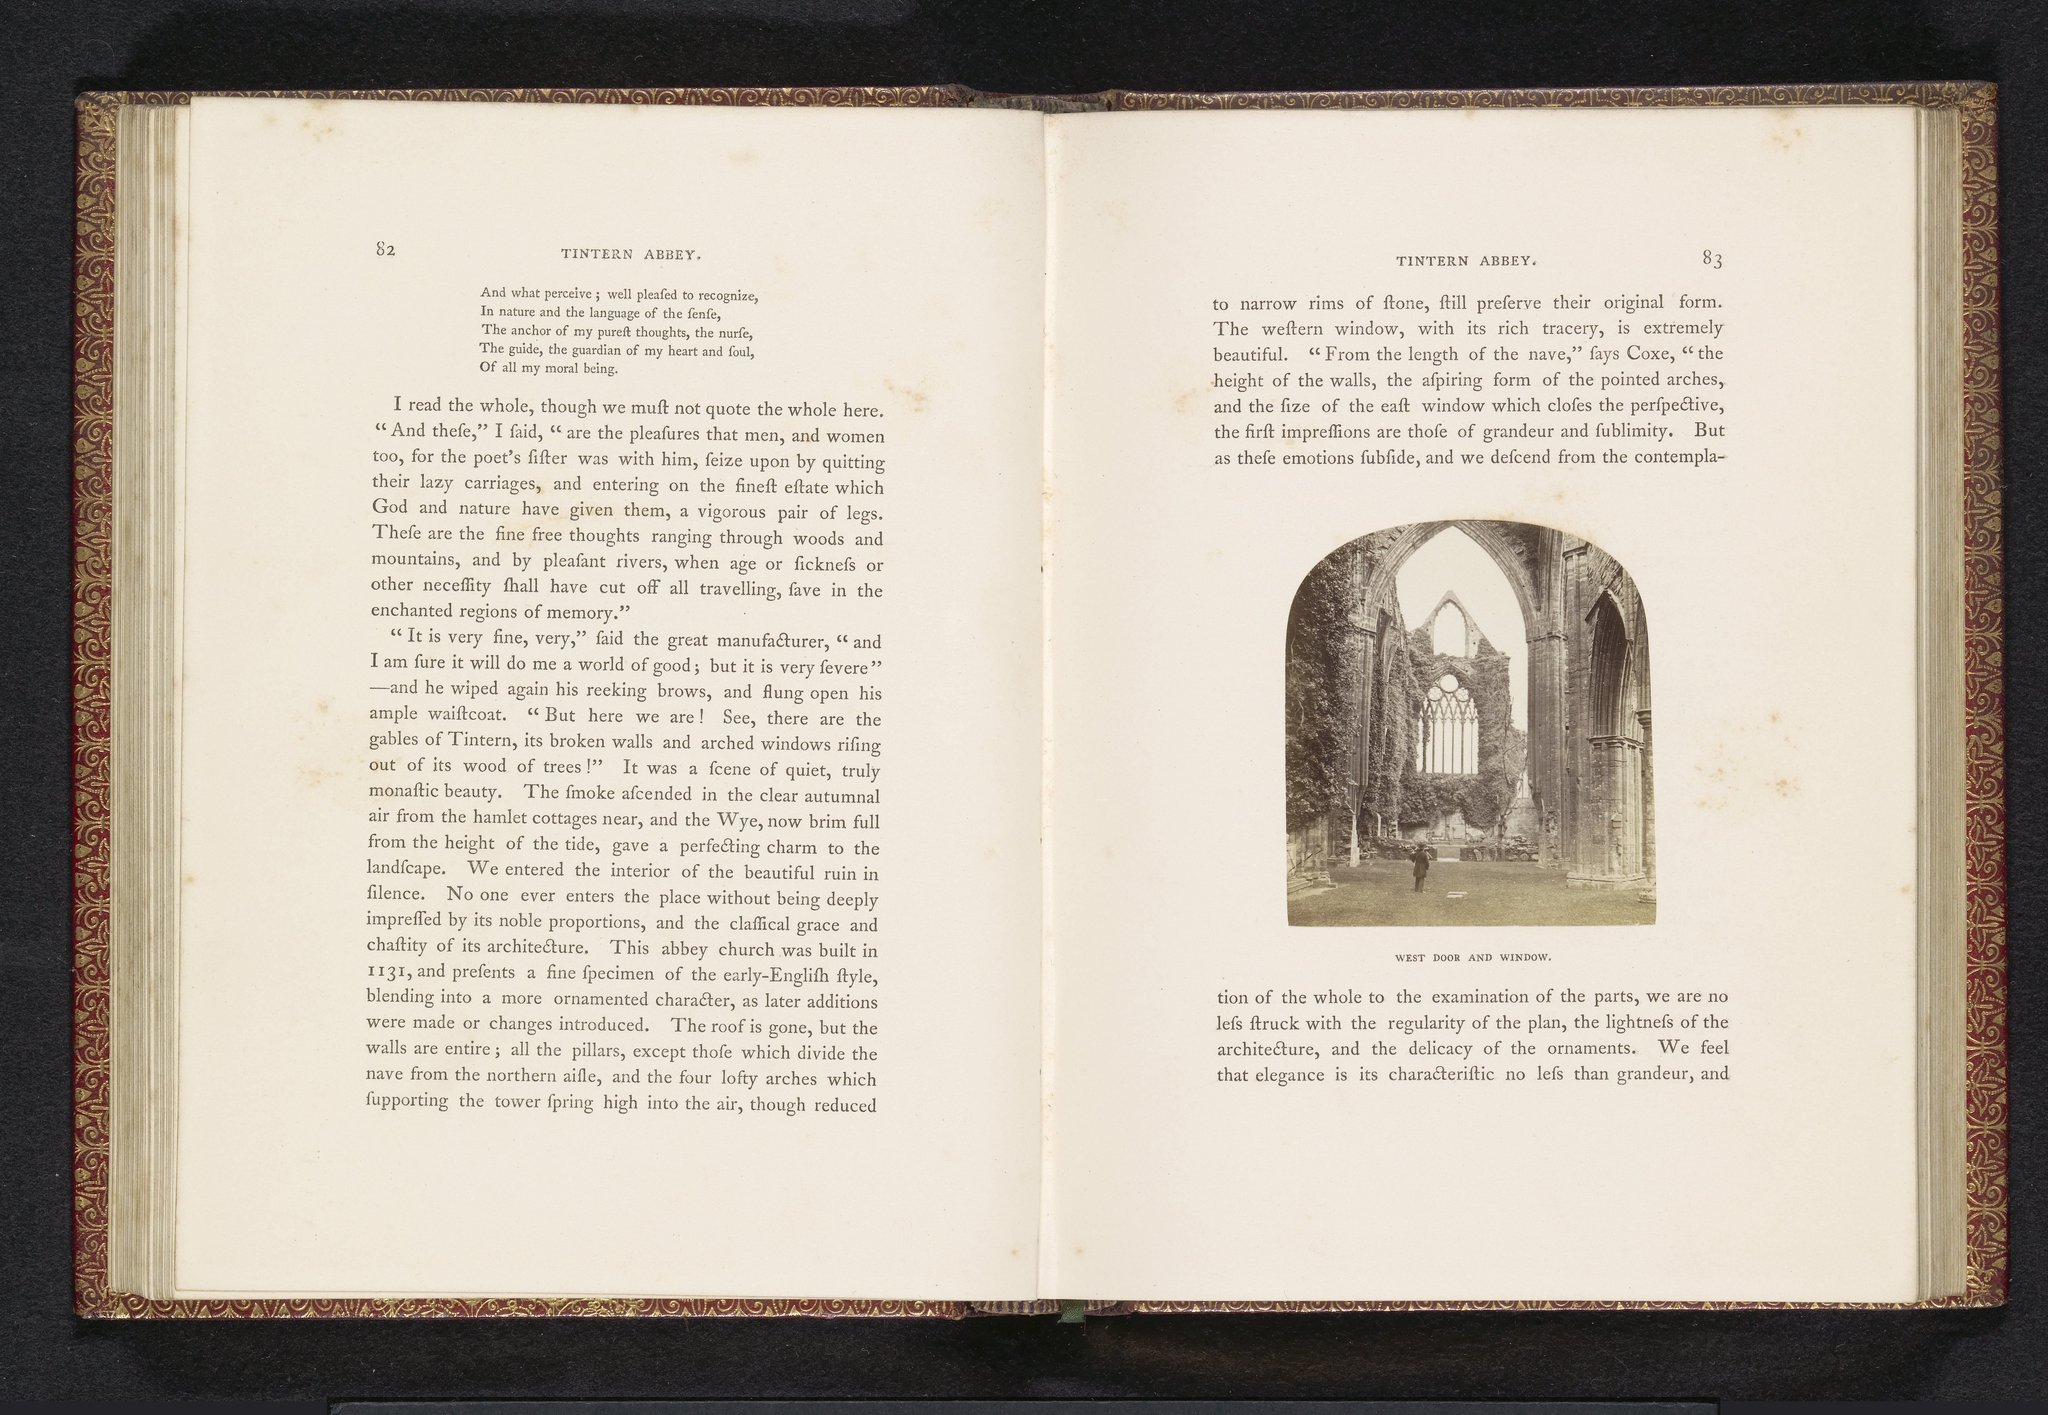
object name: photograph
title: West Door and Window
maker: william russell sedgfield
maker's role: fotograaf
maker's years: 1826-1902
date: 1852-1862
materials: photographic support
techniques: albumen print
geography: tintern abbey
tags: ruin of church, monastery, etc.